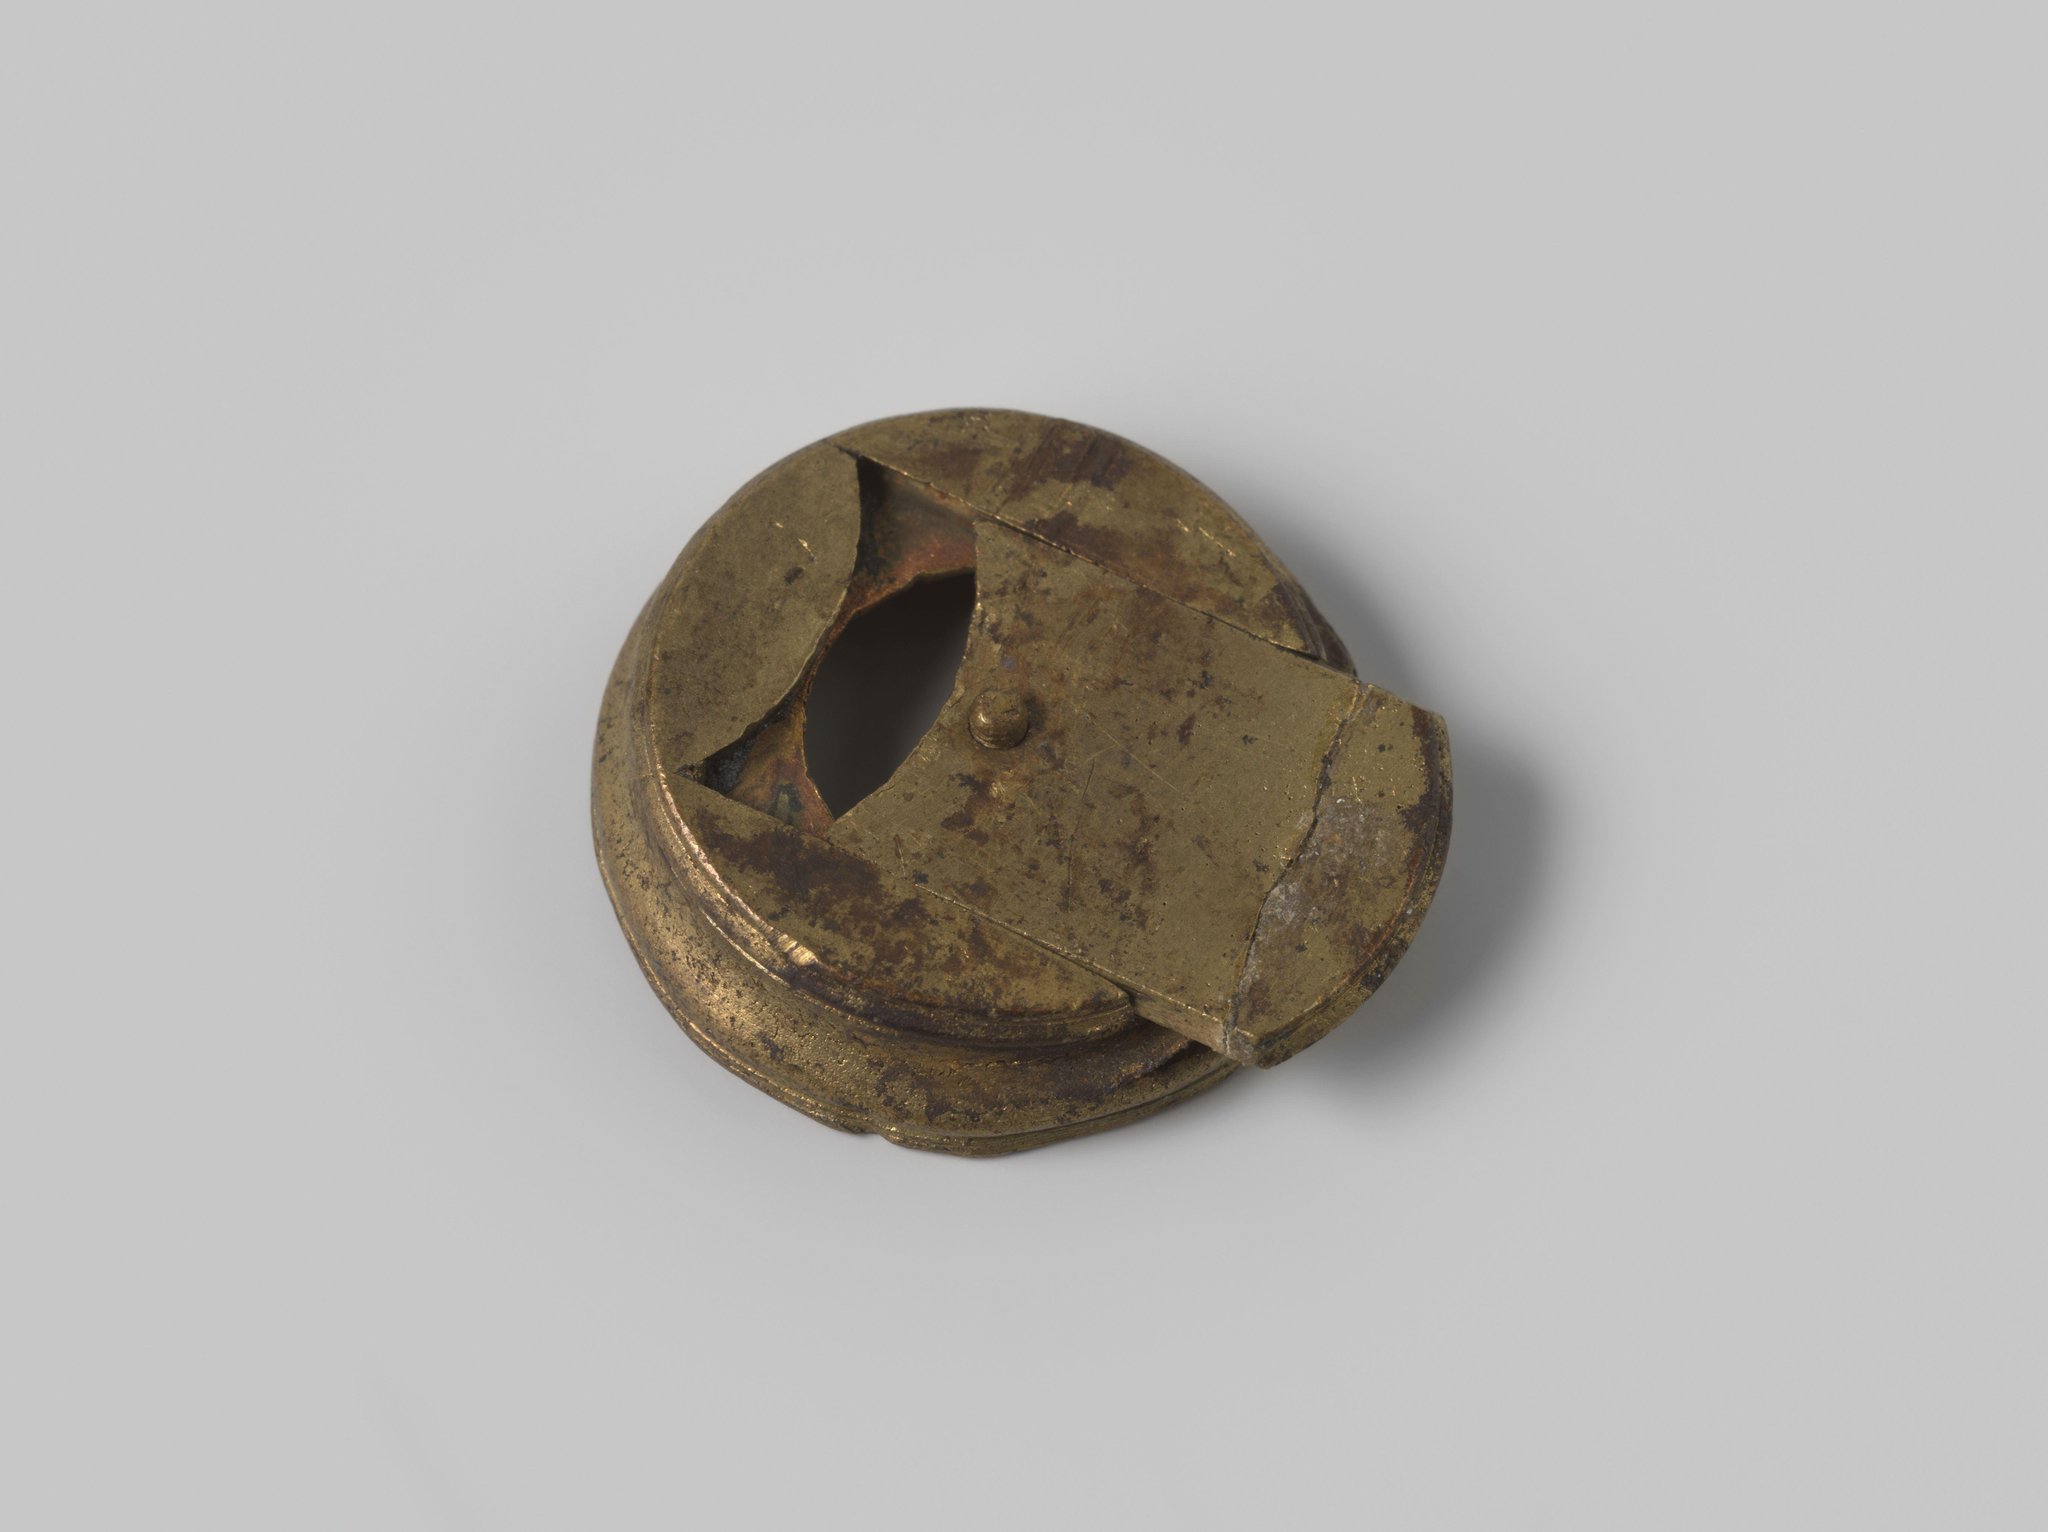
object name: optical instrument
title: Onderdeel telescoop uit het wrak van de Oost-Indiëvaarder Hollandia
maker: Anonymous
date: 1700-1743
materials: copper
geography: netherlands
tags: verenigde oostindische compagnie, hollandia (schip), annet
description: Optical instrument, telescope, lenscap, circular, stepped rim, flat top with oblong straight sliding lid, fitted with threaded pin, covering circular central opening with straight slot for pin.